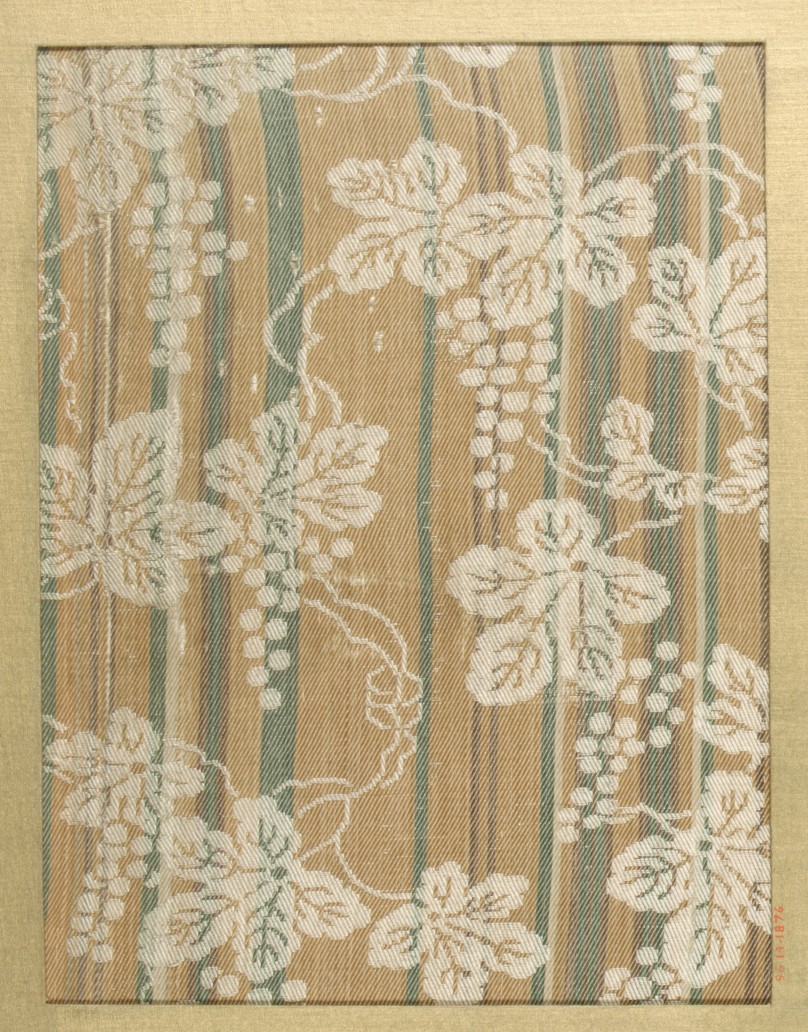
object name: piece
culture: japanese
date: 1701-1900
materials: silk